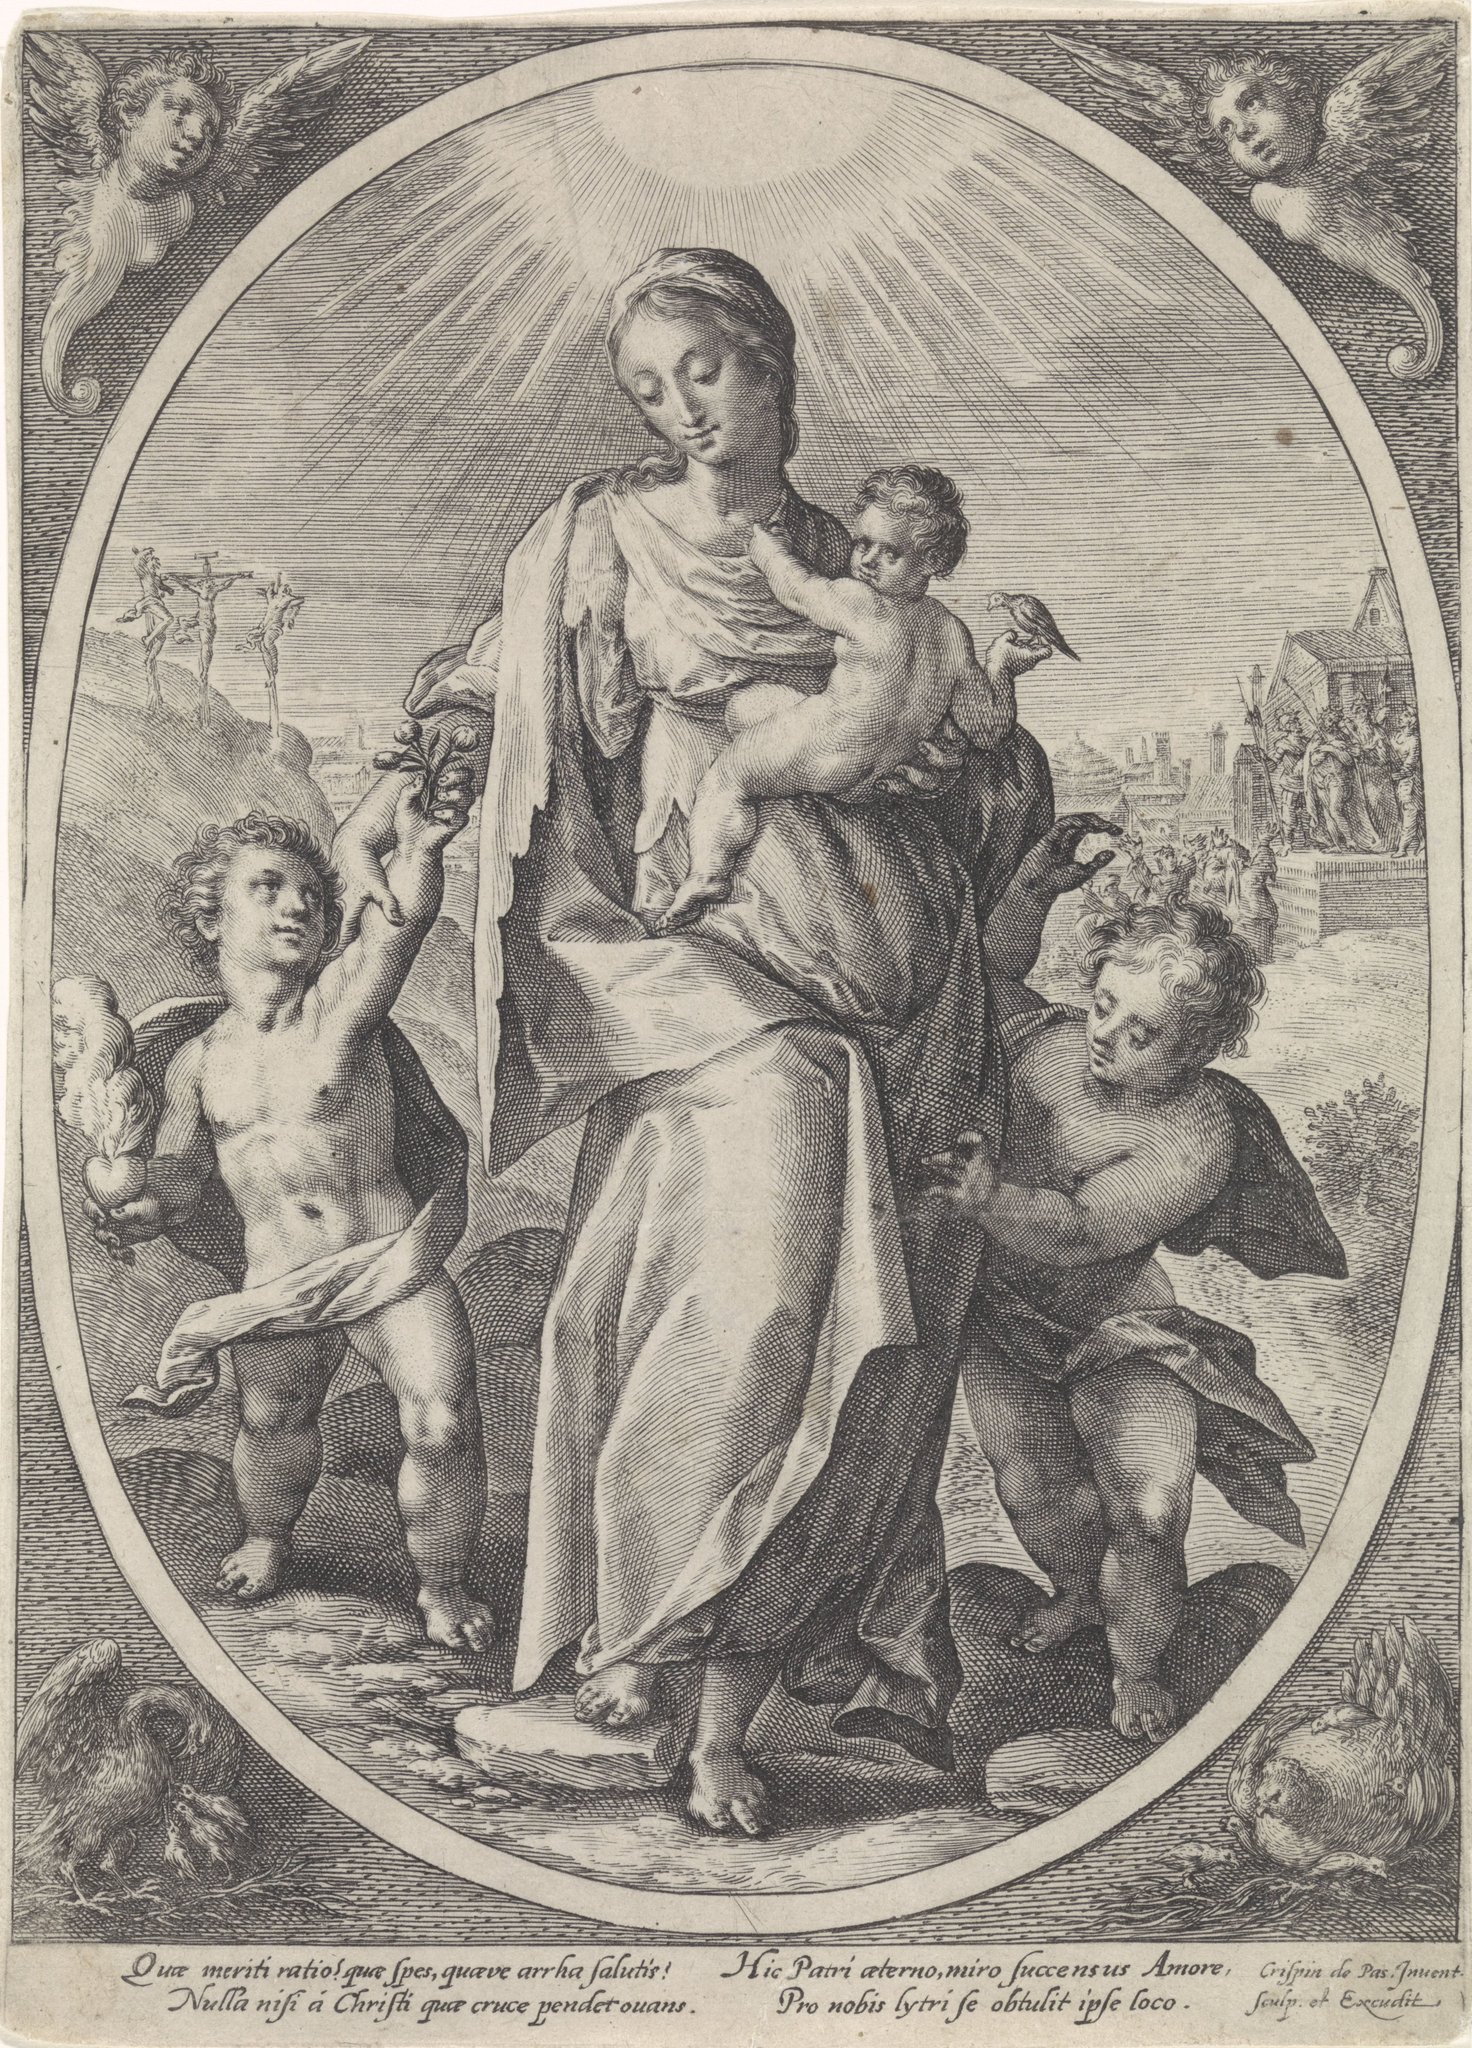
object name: print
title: Liefde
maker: crispijn van de passe (i)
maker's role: draughtsman, print maker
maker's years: 1564-1637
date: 1574-1637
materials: paper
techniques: engraving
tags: charity, 'caritas'; 'carità' (ripa) ~ one of the three theological virtues, pilate showing christ to the people, 'ostentatio christi', 'ecce homo' (john 19:4-6), the crucifixion of christ: christ's death on the cross; golgotha (matthew 27:45-58; mark 15:33-45; luke 23:44-52; john 19:25-38)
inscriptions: collector's mark: Lugt 2228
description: De vrouwelijke personificatie van Liefde (Caritas), vergezeld door kinderen. Eén van hen houdt een vlammend hart vast. Links op de achtergrond de kruisiging en rechts op de achtergrond wordt Christus aan het volk getoond. In de marge een vierregelig onderschrift, in twee kolommen, in het Latijn.